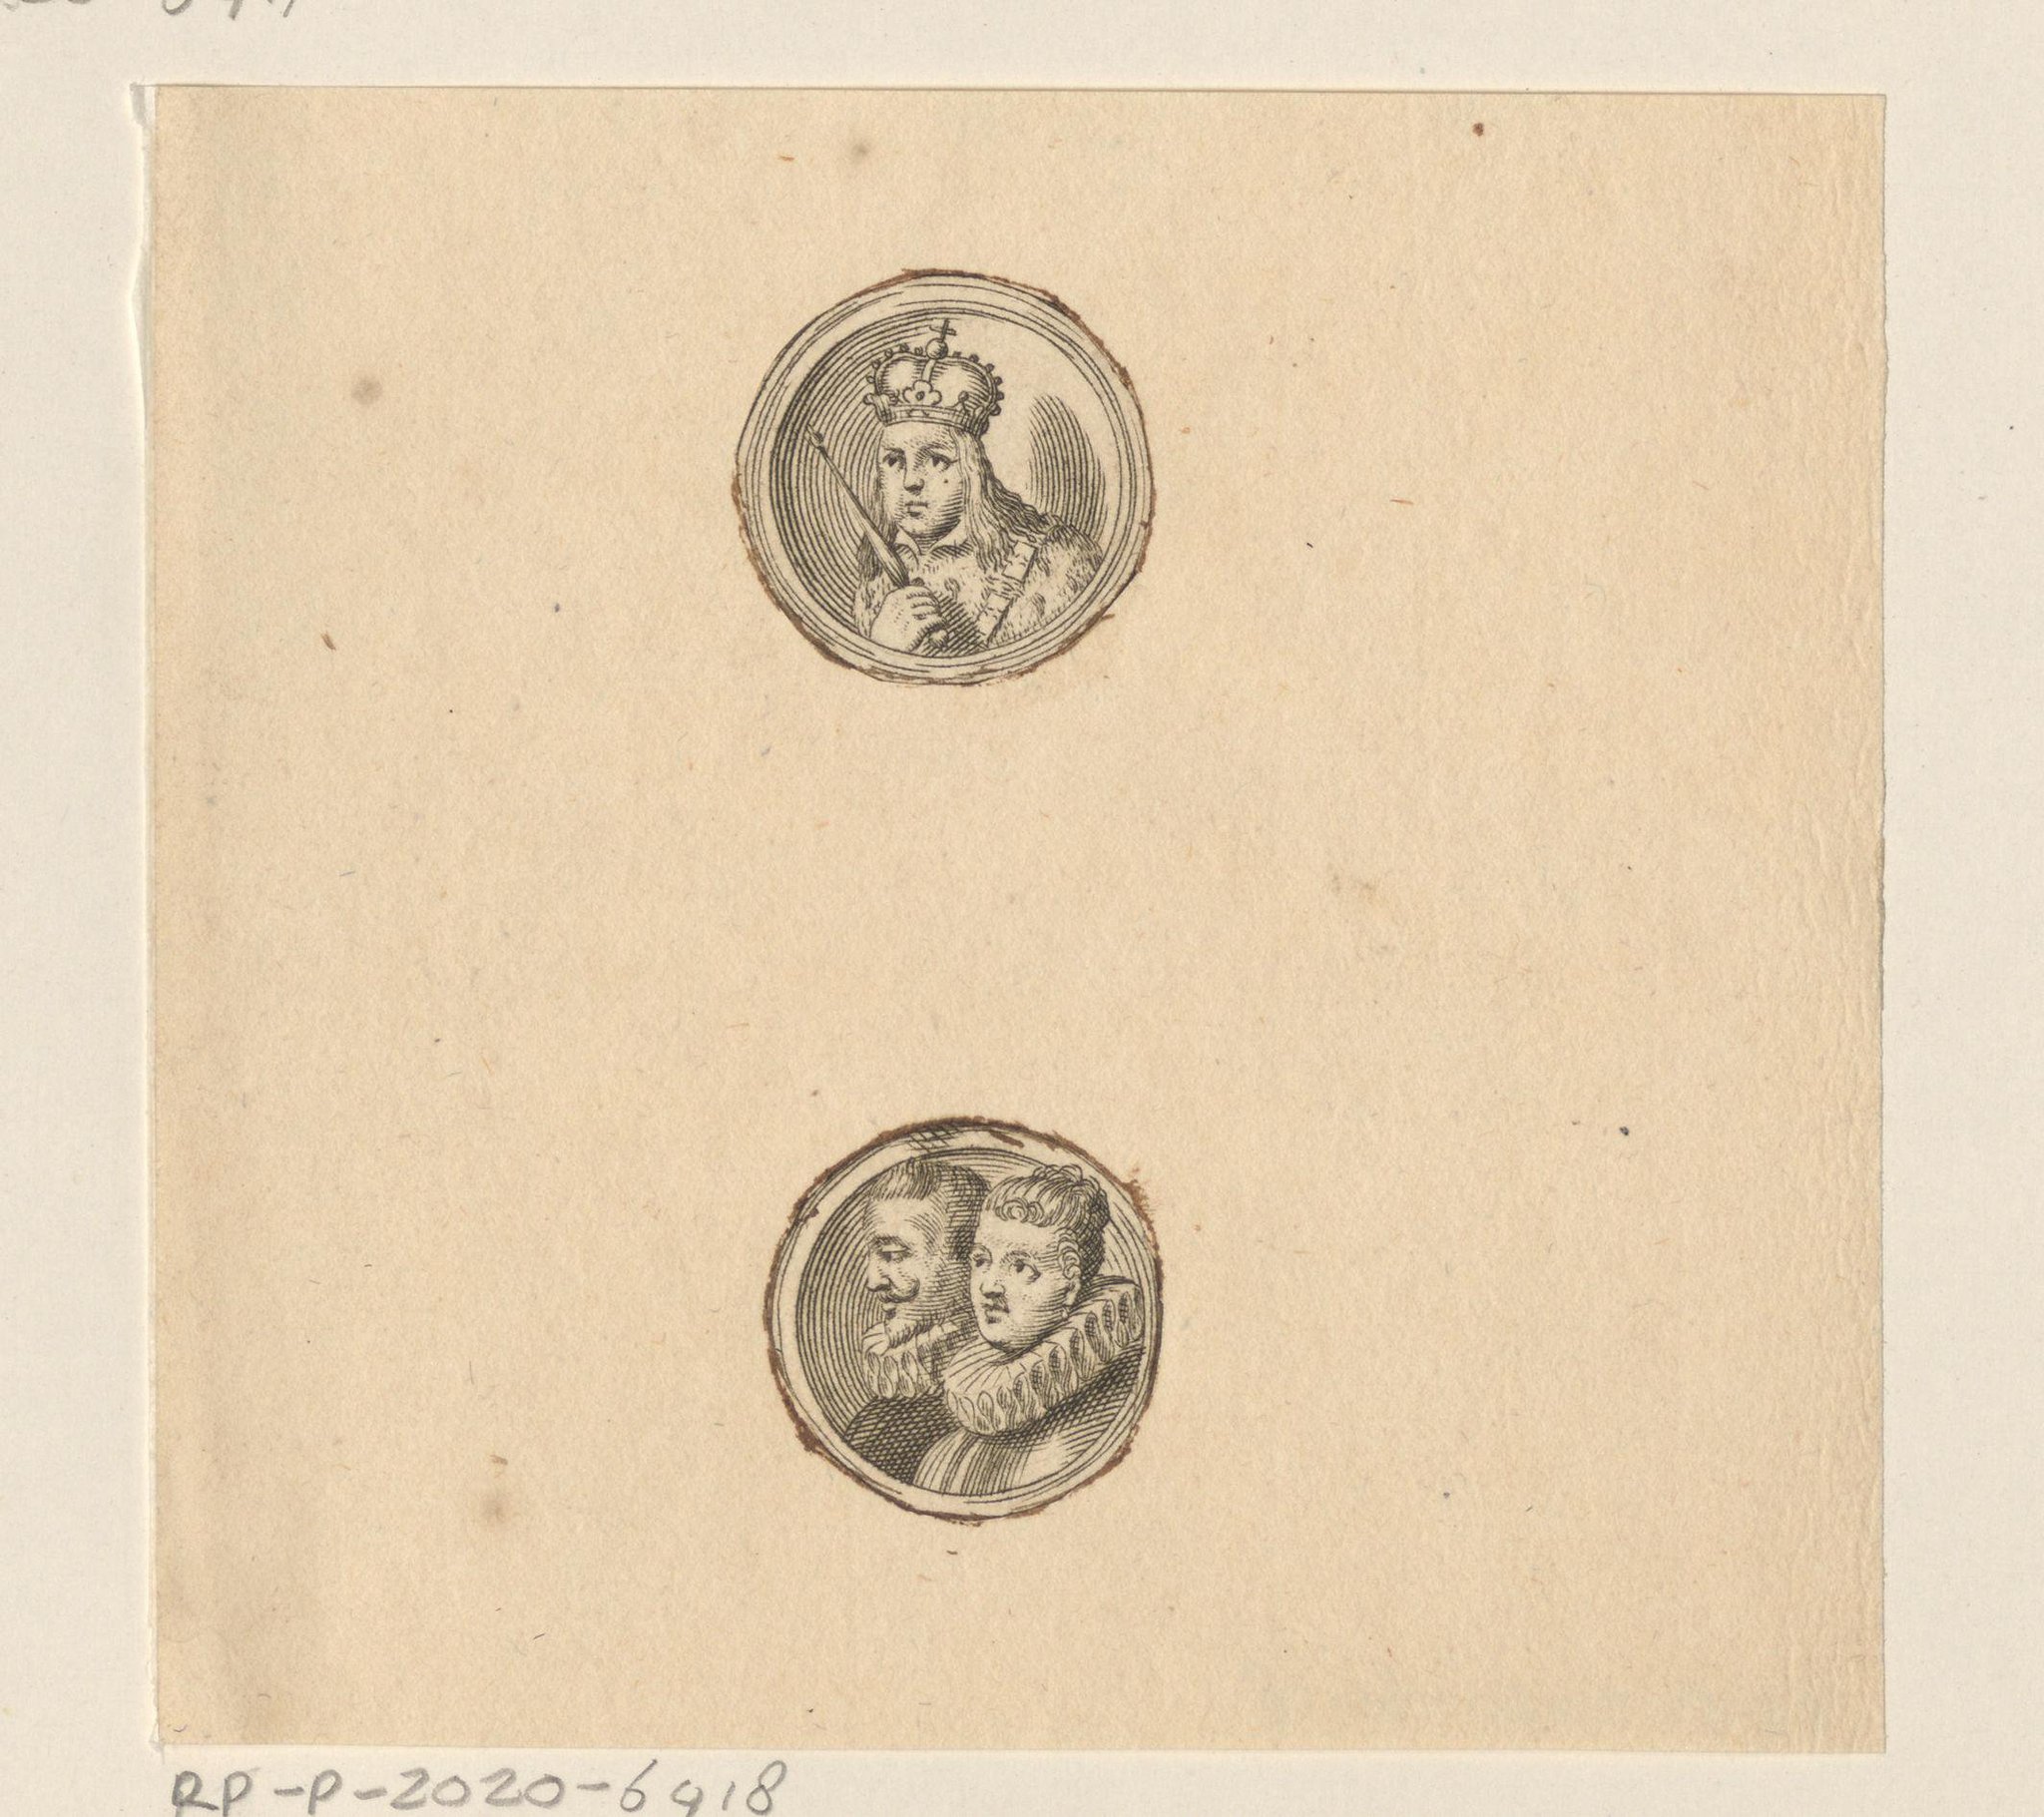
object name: print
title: Portret van een onbekende koning met scepter en portret van Albrecht, aartshertog van Oostenrijk en Isabella Clara Eugenia, infante van Spanje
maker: Anonymous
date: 1600-1699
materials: paper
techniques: engraving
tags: infante van spanje isabella clara eugenia, albrecht aartshertog van oostenrijk, historical persons - bb - woman, historical persons, ruler, sovereign - bb - female ruler, ruler, sovereign